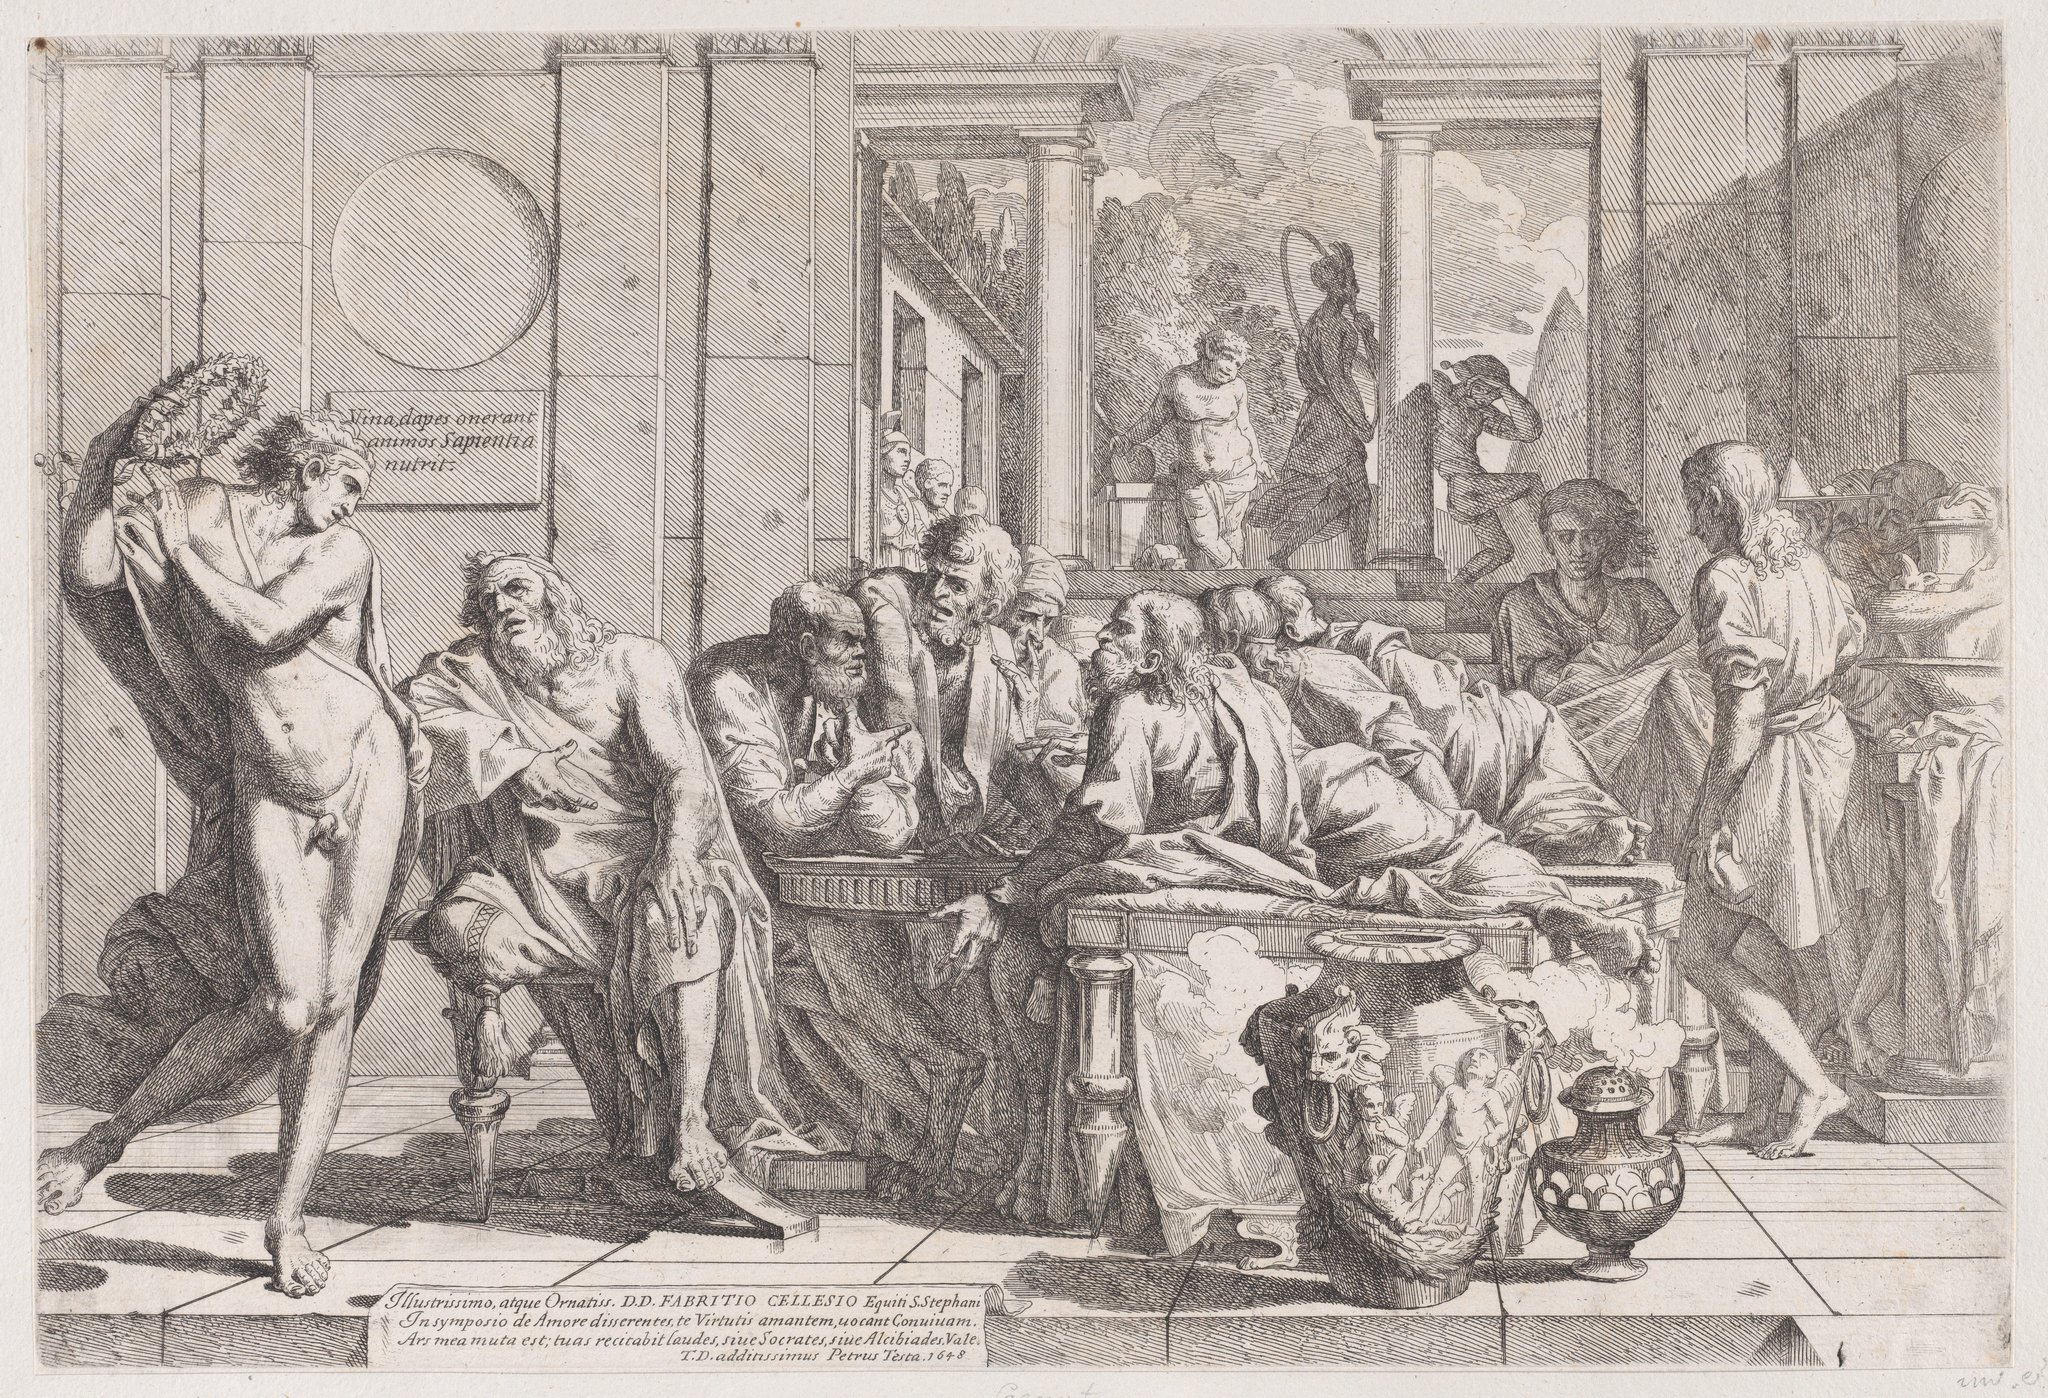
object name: print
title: Plato's symposium: Socrates and his companions seated around a table discussing ideal love interruputed by Acibiades at left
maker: pietro testa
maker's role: artist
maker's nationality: italian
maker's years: 1612-1650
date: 1648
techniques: etching